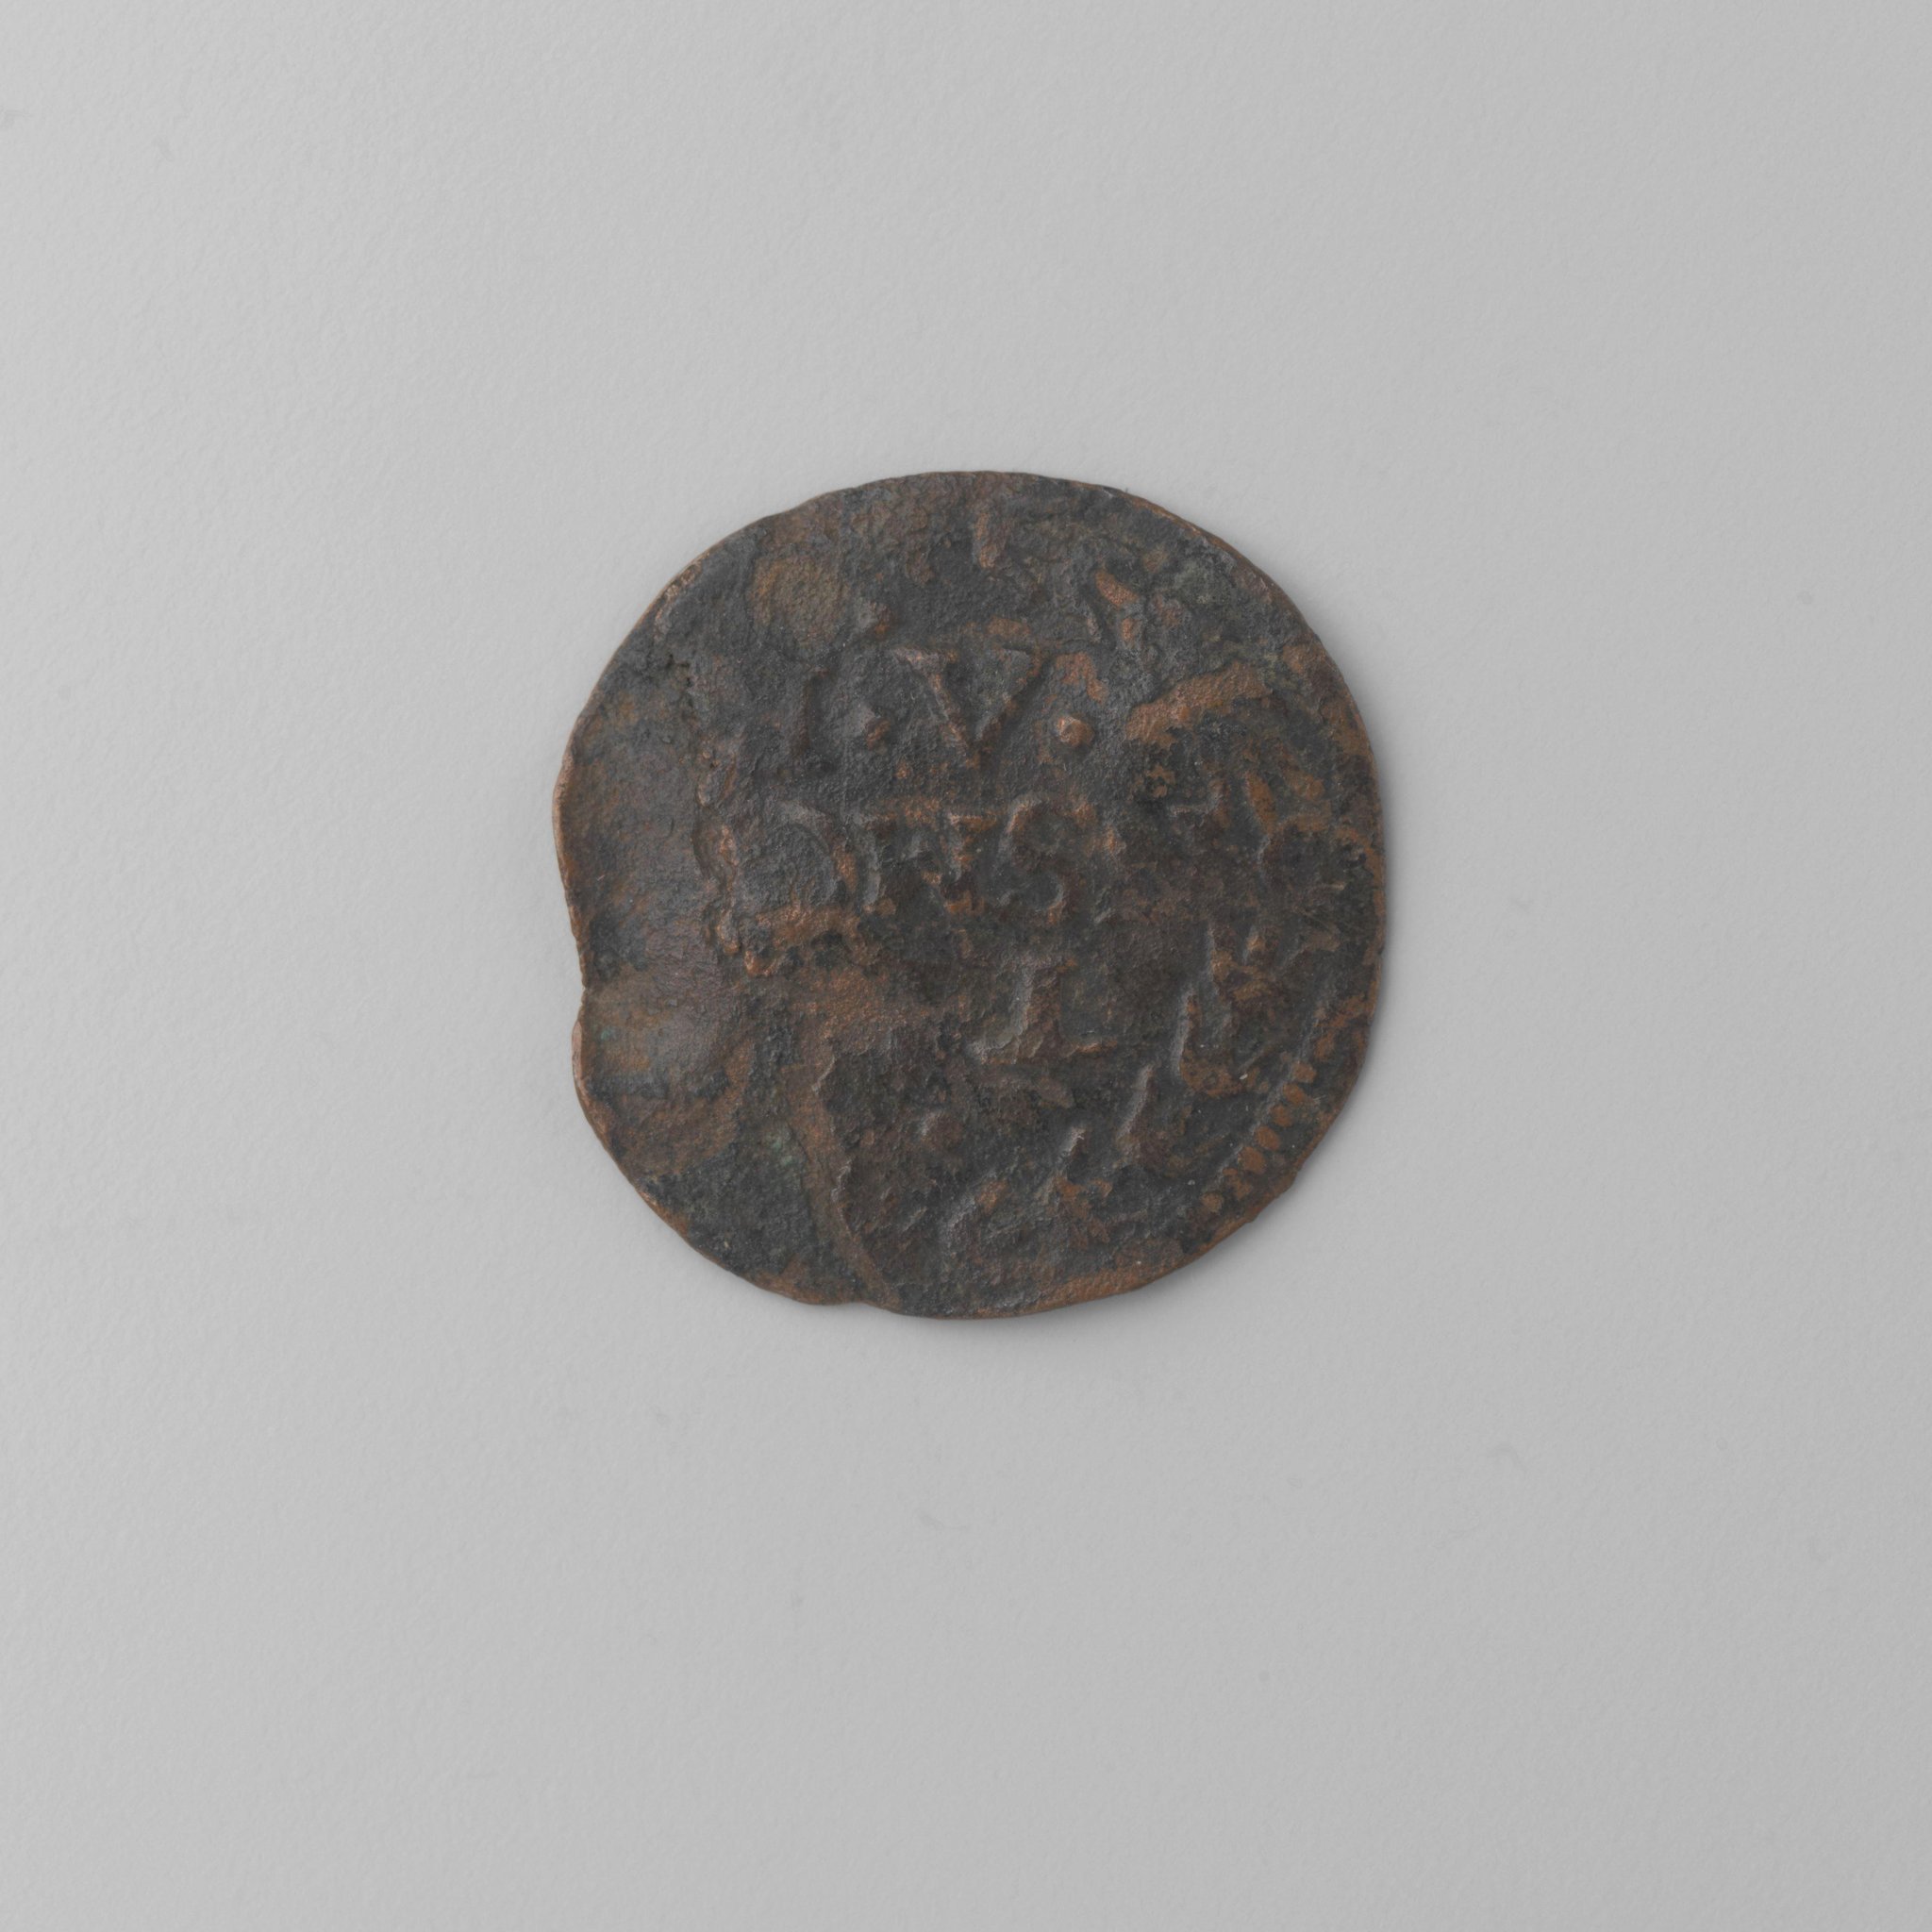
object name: coin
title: Reckheimse duit van Ferdinand van Aspremont-Lynden (1636-1665)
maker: heer van reckheim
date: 1636-1665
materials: copper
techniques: striking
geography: rekem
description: Koperen munt. Voorzijde: versierd gekroond wapenschild van Holland. Keerzijde: binnen een krans drie-regelig opschrift.